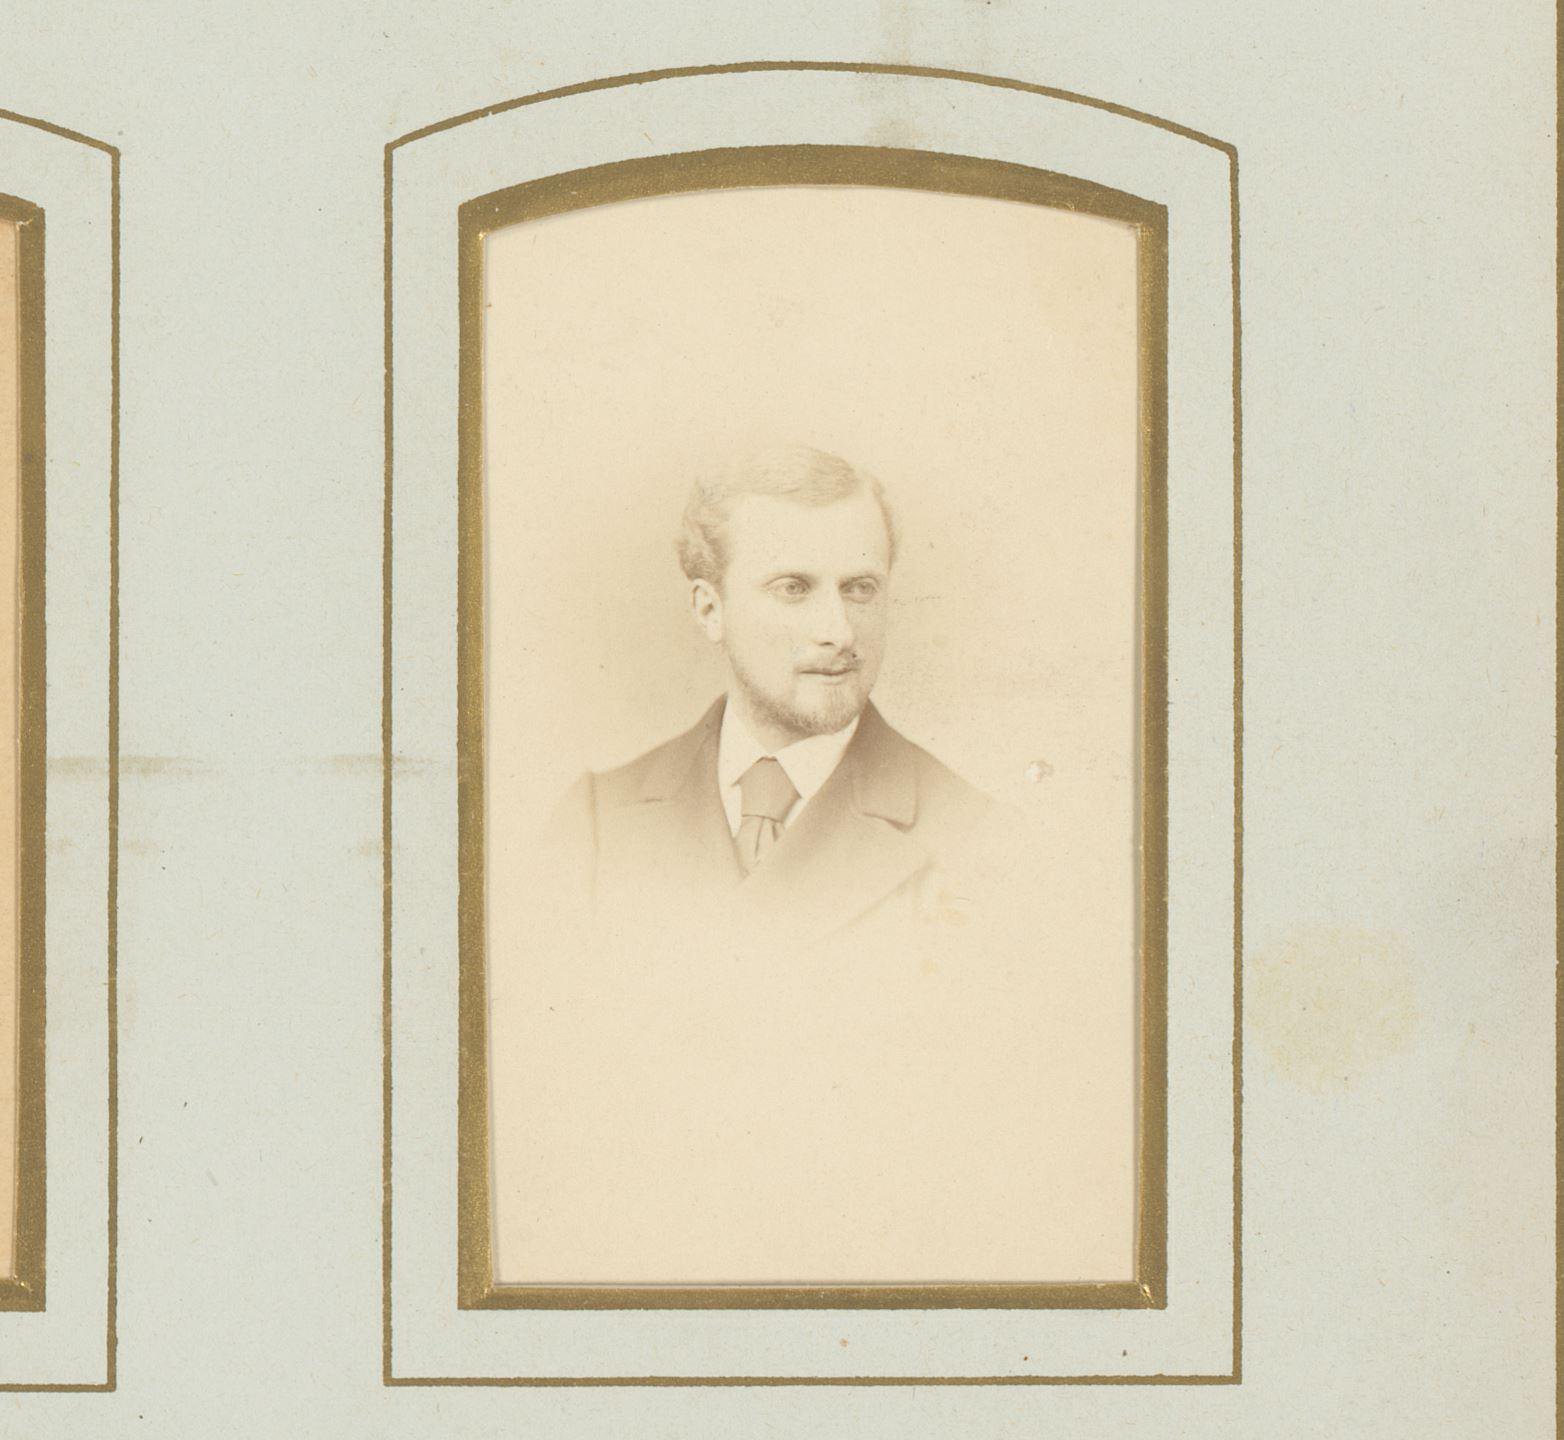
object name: album leaf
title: Portret van een man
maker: augustin aimé joseph lejeune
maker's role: fotograaf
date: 1850-1900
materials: cardboard, photographic support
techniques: albumen print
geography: paris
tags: historical persons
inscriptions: inscription: ‘Le Jeune/ Photographe Breveté/ de S. A. le Prince Impérial’